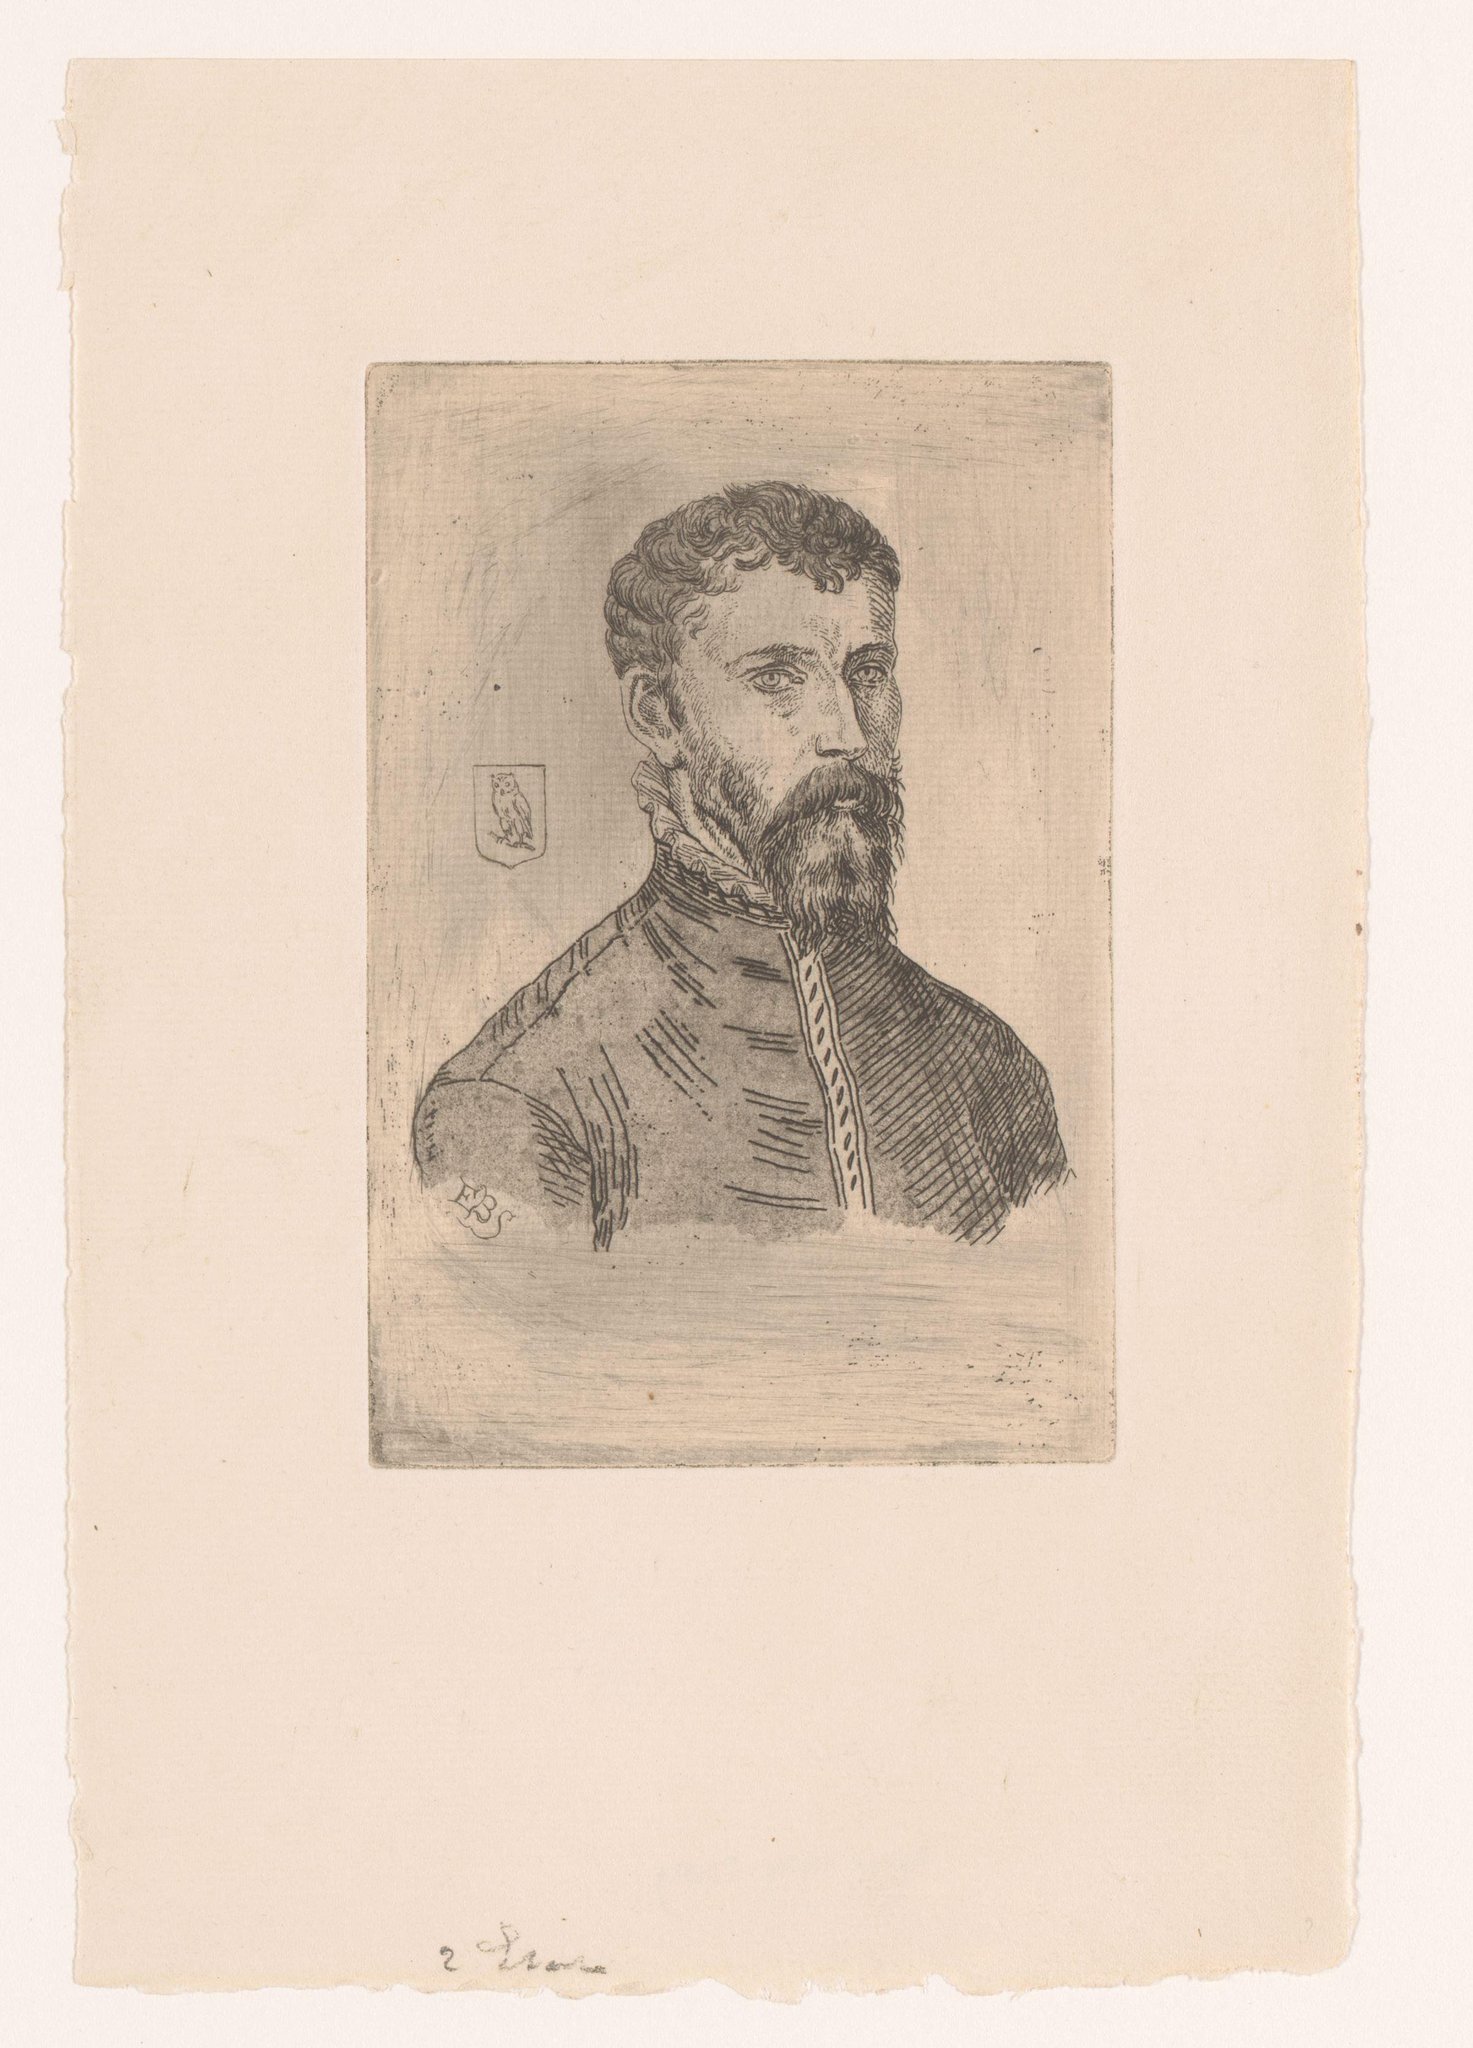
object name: print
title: Portret van Herri met de Bles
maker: edgar alfred baes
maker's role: print maker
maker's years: 1837-1909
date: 1847-1909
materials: paper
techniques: etching, intaglio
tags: herri met de bles, portrait, self-portrait of painter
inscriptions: collector's mark: Lugt 2228